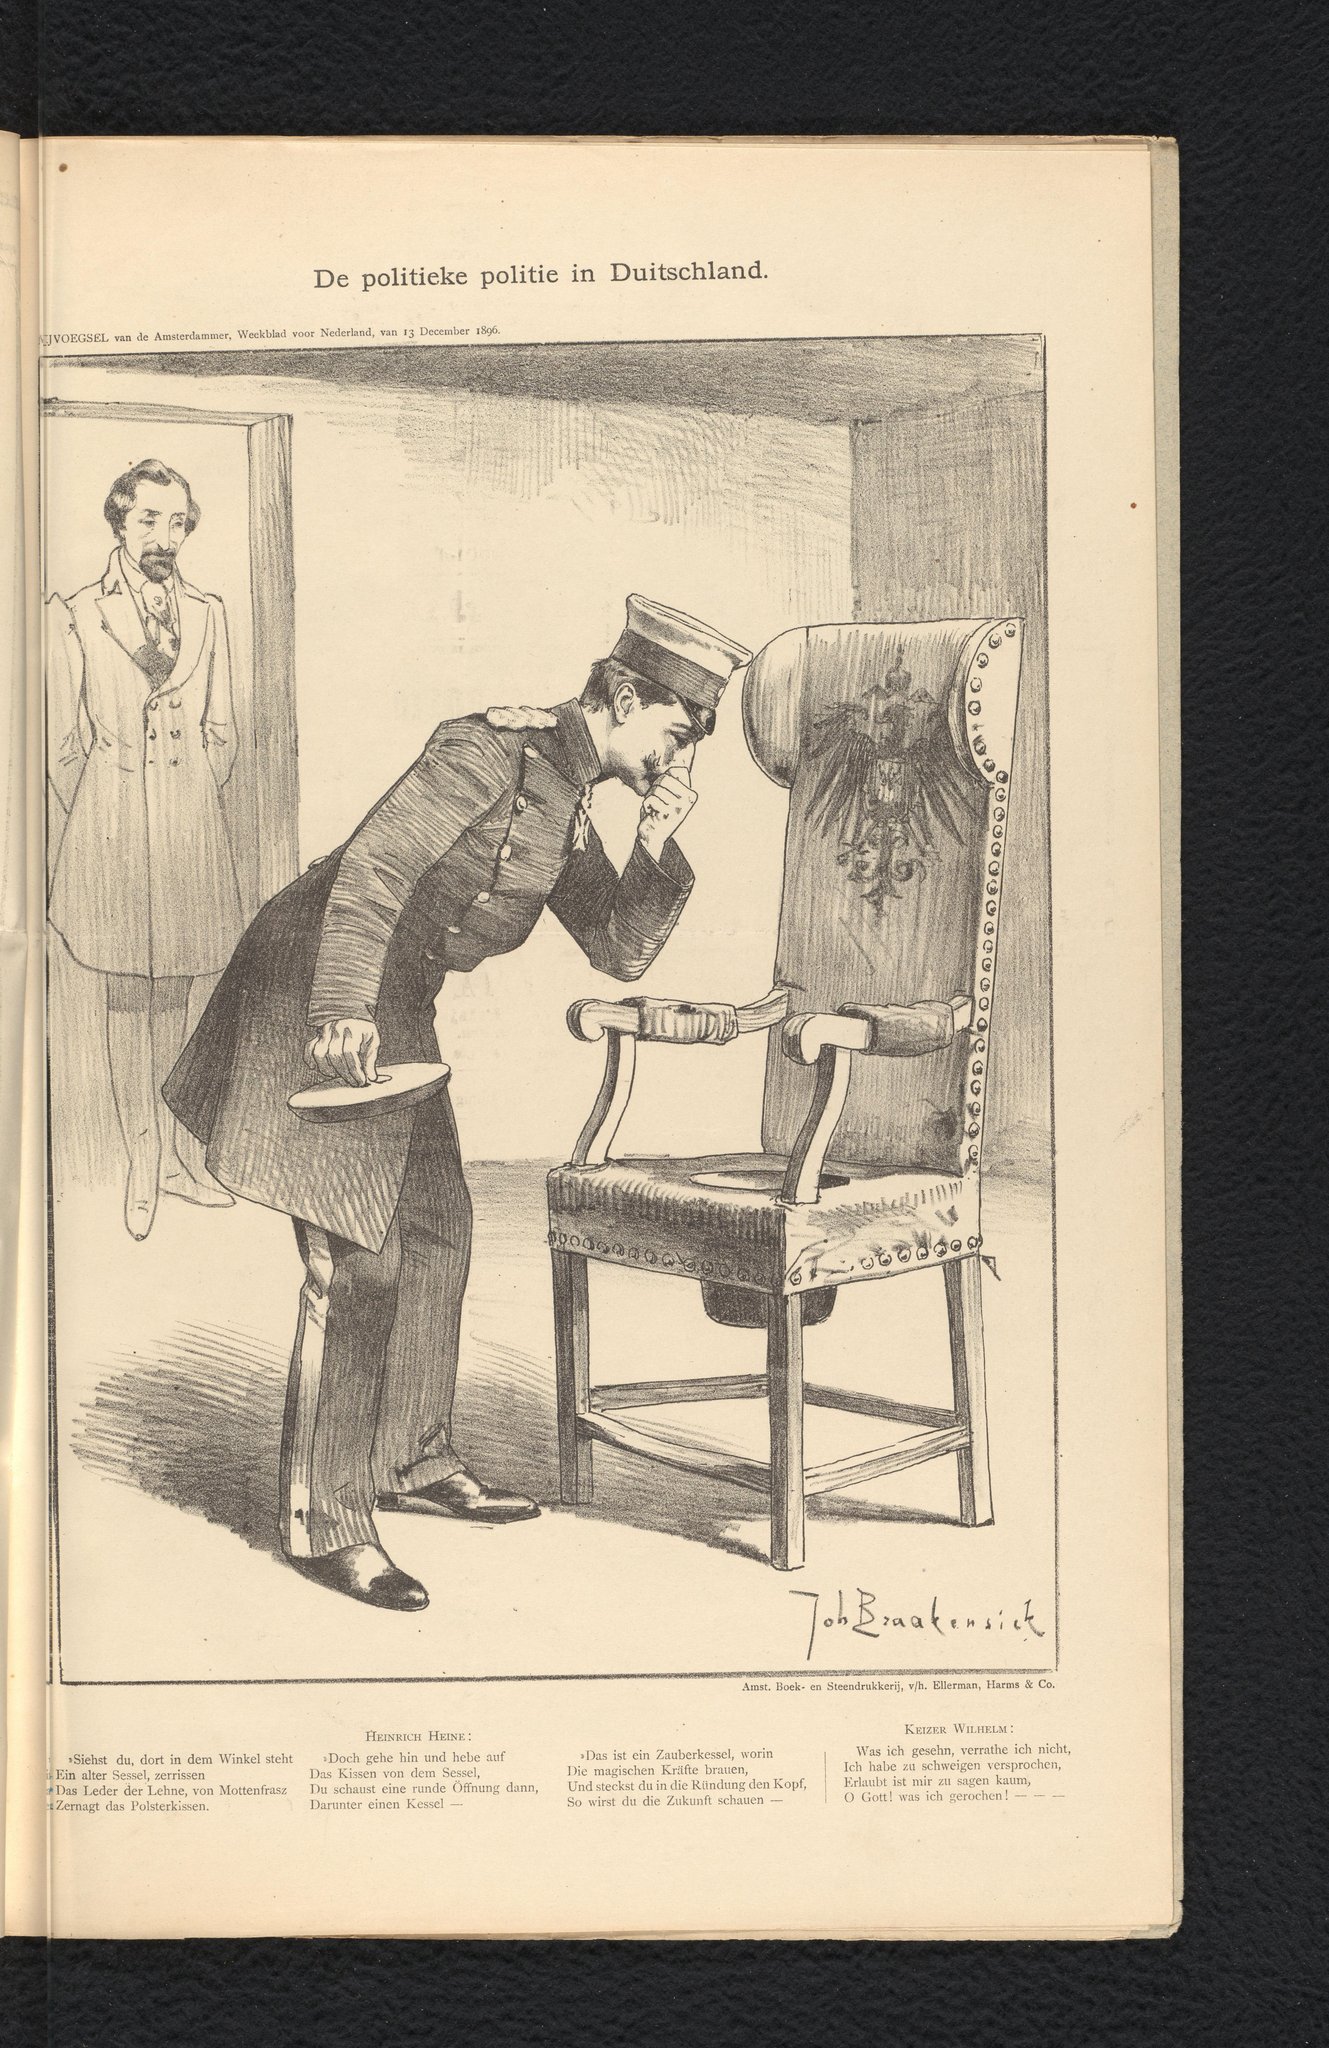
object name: cartoon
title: De politieke politie in Duitschland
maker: johan braakensiek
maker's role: draughtsman, print maker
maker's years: 1858-1940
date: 1896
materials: paper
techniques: lithograph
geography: amsterdam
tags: paris, heinrich heine, wilhelm ii (keizer van duitsland), personifications of countries, nations, states, districts, etc., disagreeable, repellent smell, chamber-pot, political caricatures and satires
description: De dichter Heinrich Heine ziet toe hoe keizer Wilhelm II met toegeknepen neus een stoel met stinkende kakdoos (het Duitse keizerrijk) inspecteert.